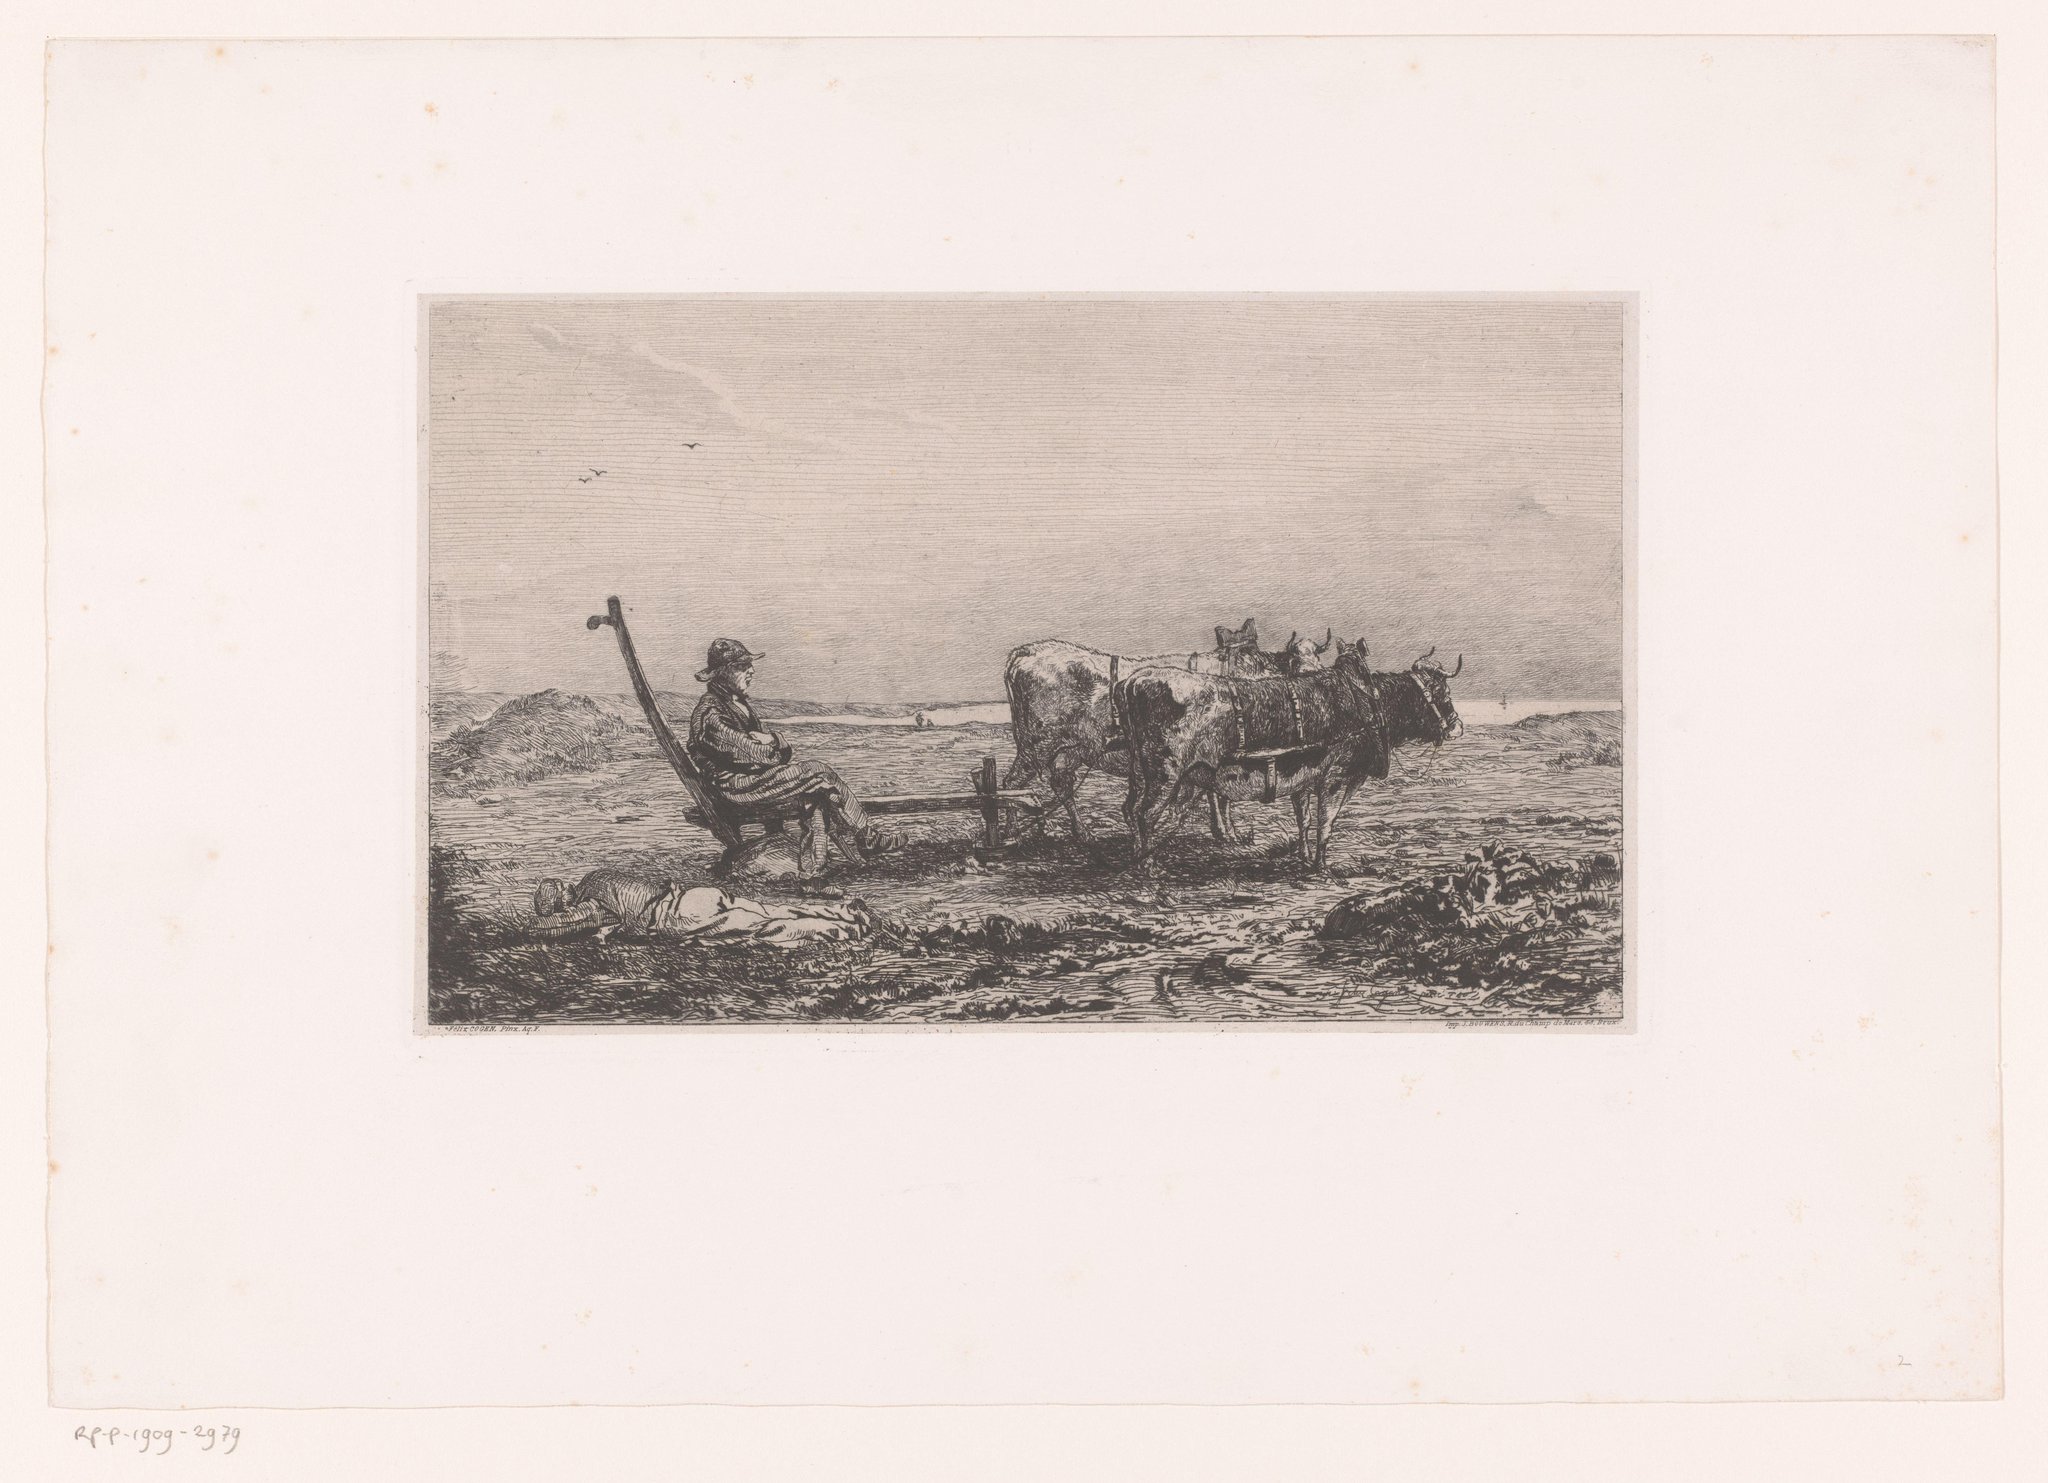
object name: print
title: Boeren op het land met een ploeg en twee runderen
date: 1848-1907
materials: paper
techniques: drypoint, etching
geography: brussels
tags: farmers, agricultural implements: plough, bovine cattle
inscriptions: collector's mark: Lugt 2228